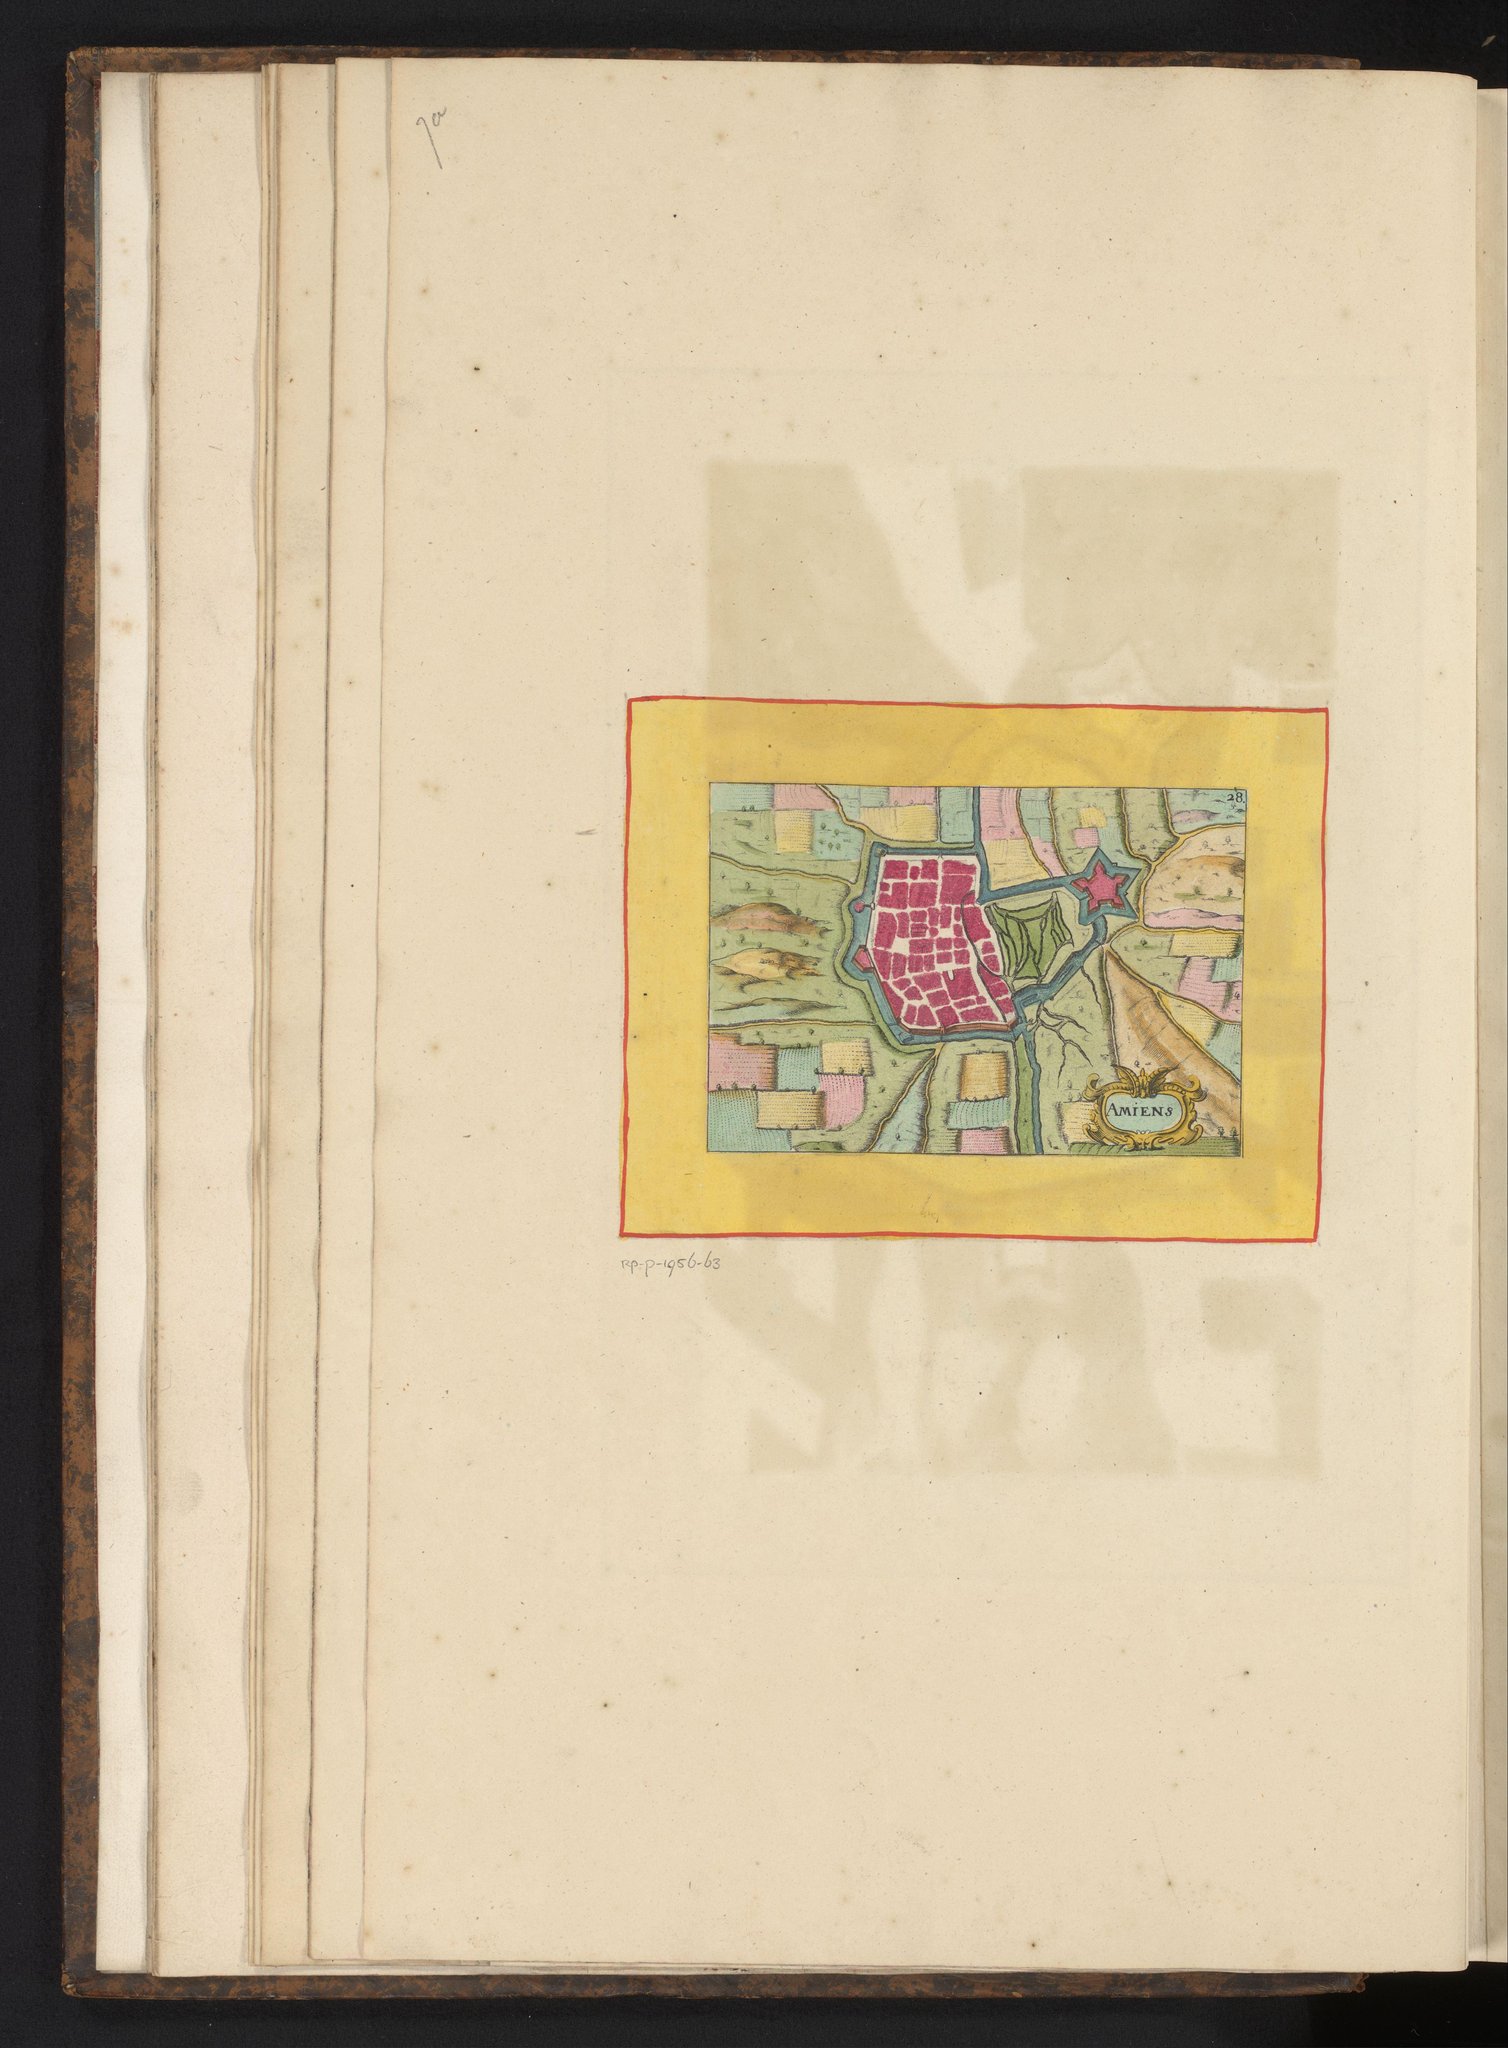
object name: area plan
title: Amiens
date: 1638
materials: paper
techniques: engraving, etching, hand coloring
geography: the hague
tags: maps of cities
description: Prent uit: Tassin, Christophe. Les plans et profils de toutes les principales villes et lieux considérables de France (...). Parijs: Michel van Lochom, 1638, kaart 28.